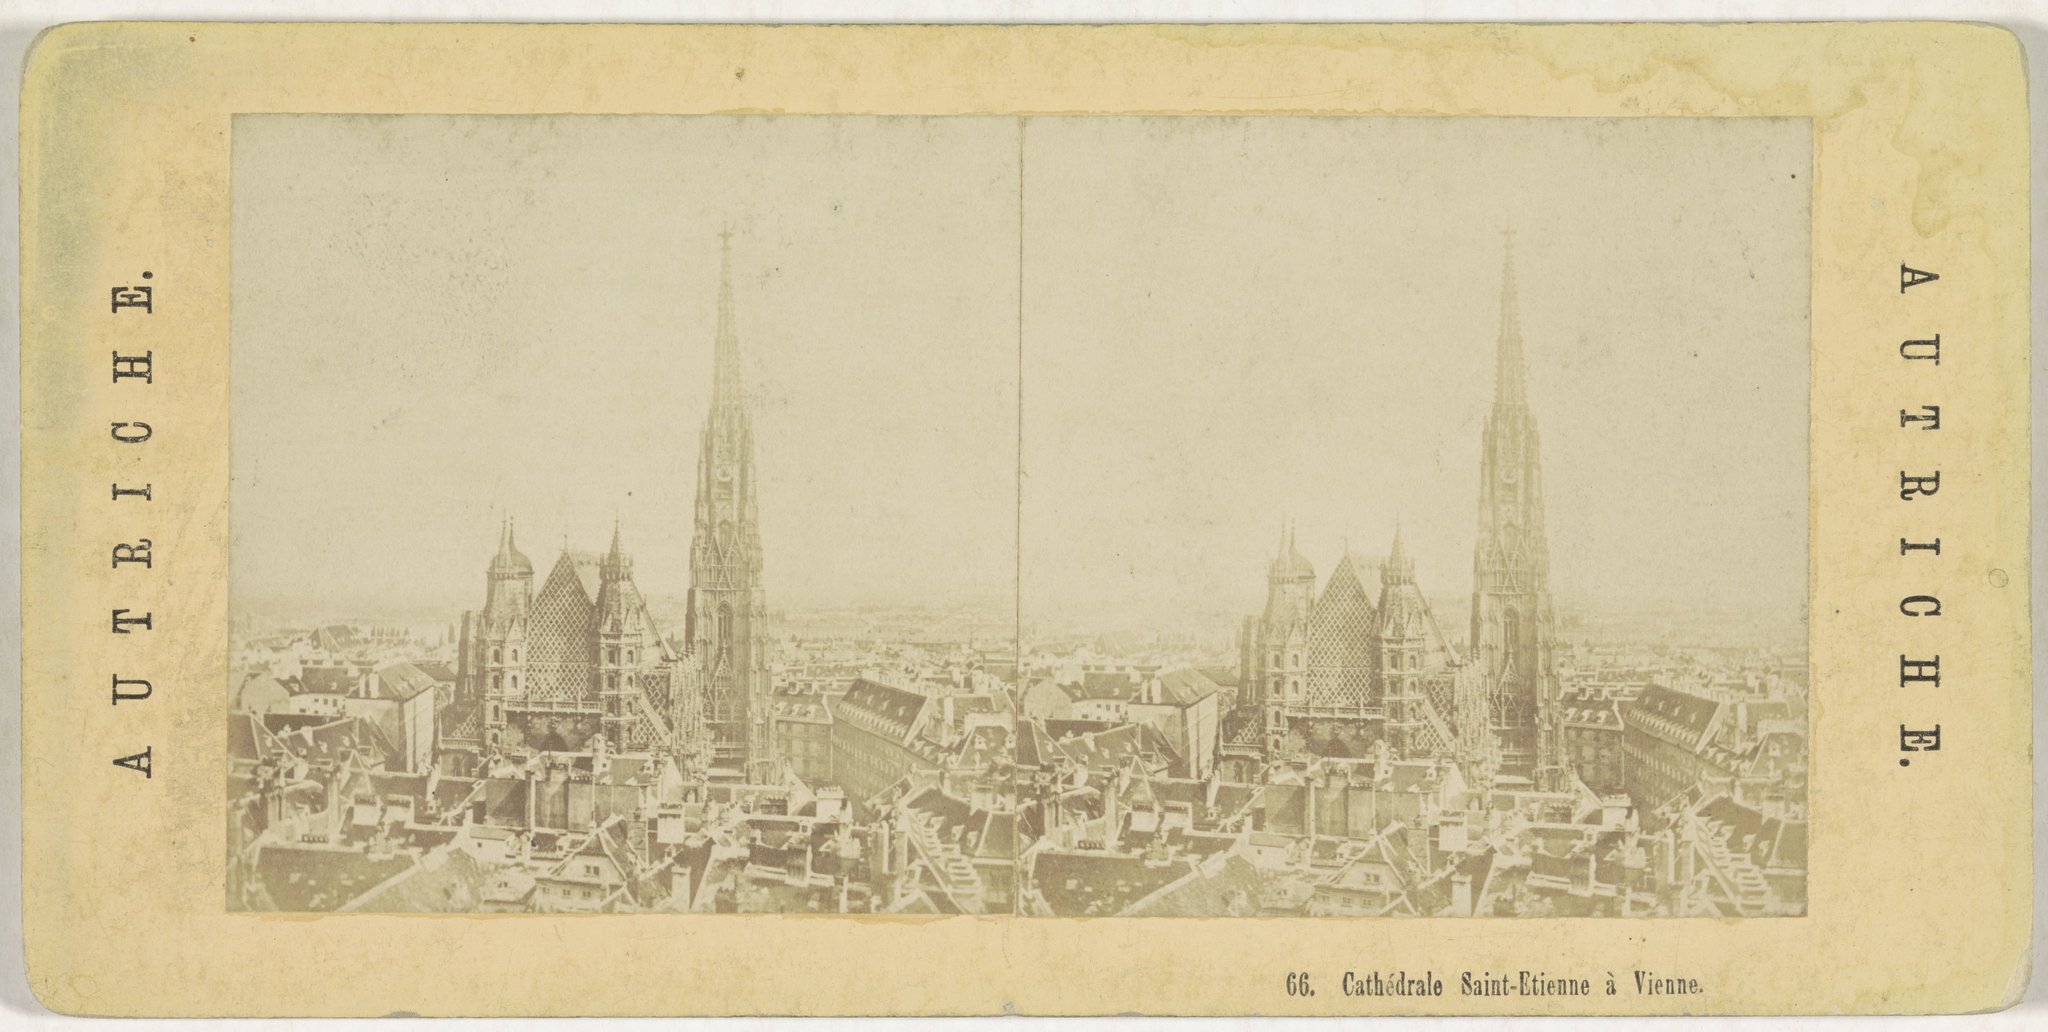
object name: stereograph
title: Gezicht op de Stephansdom in Wenen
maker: Anonymous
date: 1868-1890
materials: cardboard, paper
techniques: albumen print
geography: vienna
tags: church (exterior)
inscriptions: number: ‘66’